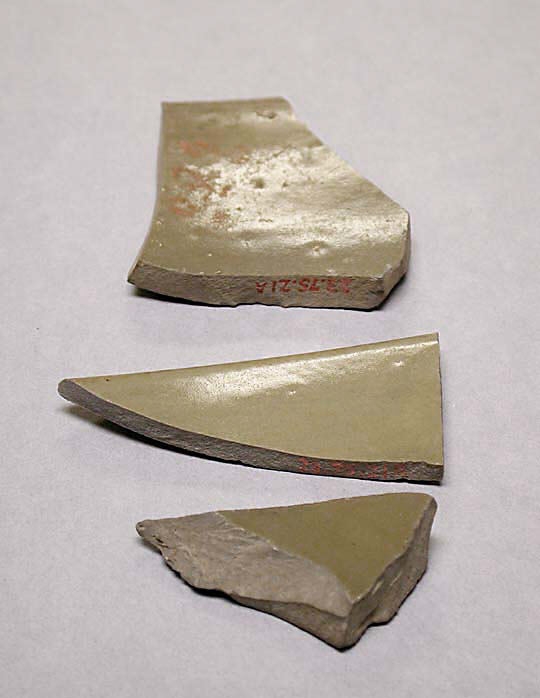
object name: fragment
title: Three Fragments of Yue Ware Bowls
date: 801-900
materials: stoneware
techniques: celadon glazed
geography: iraq